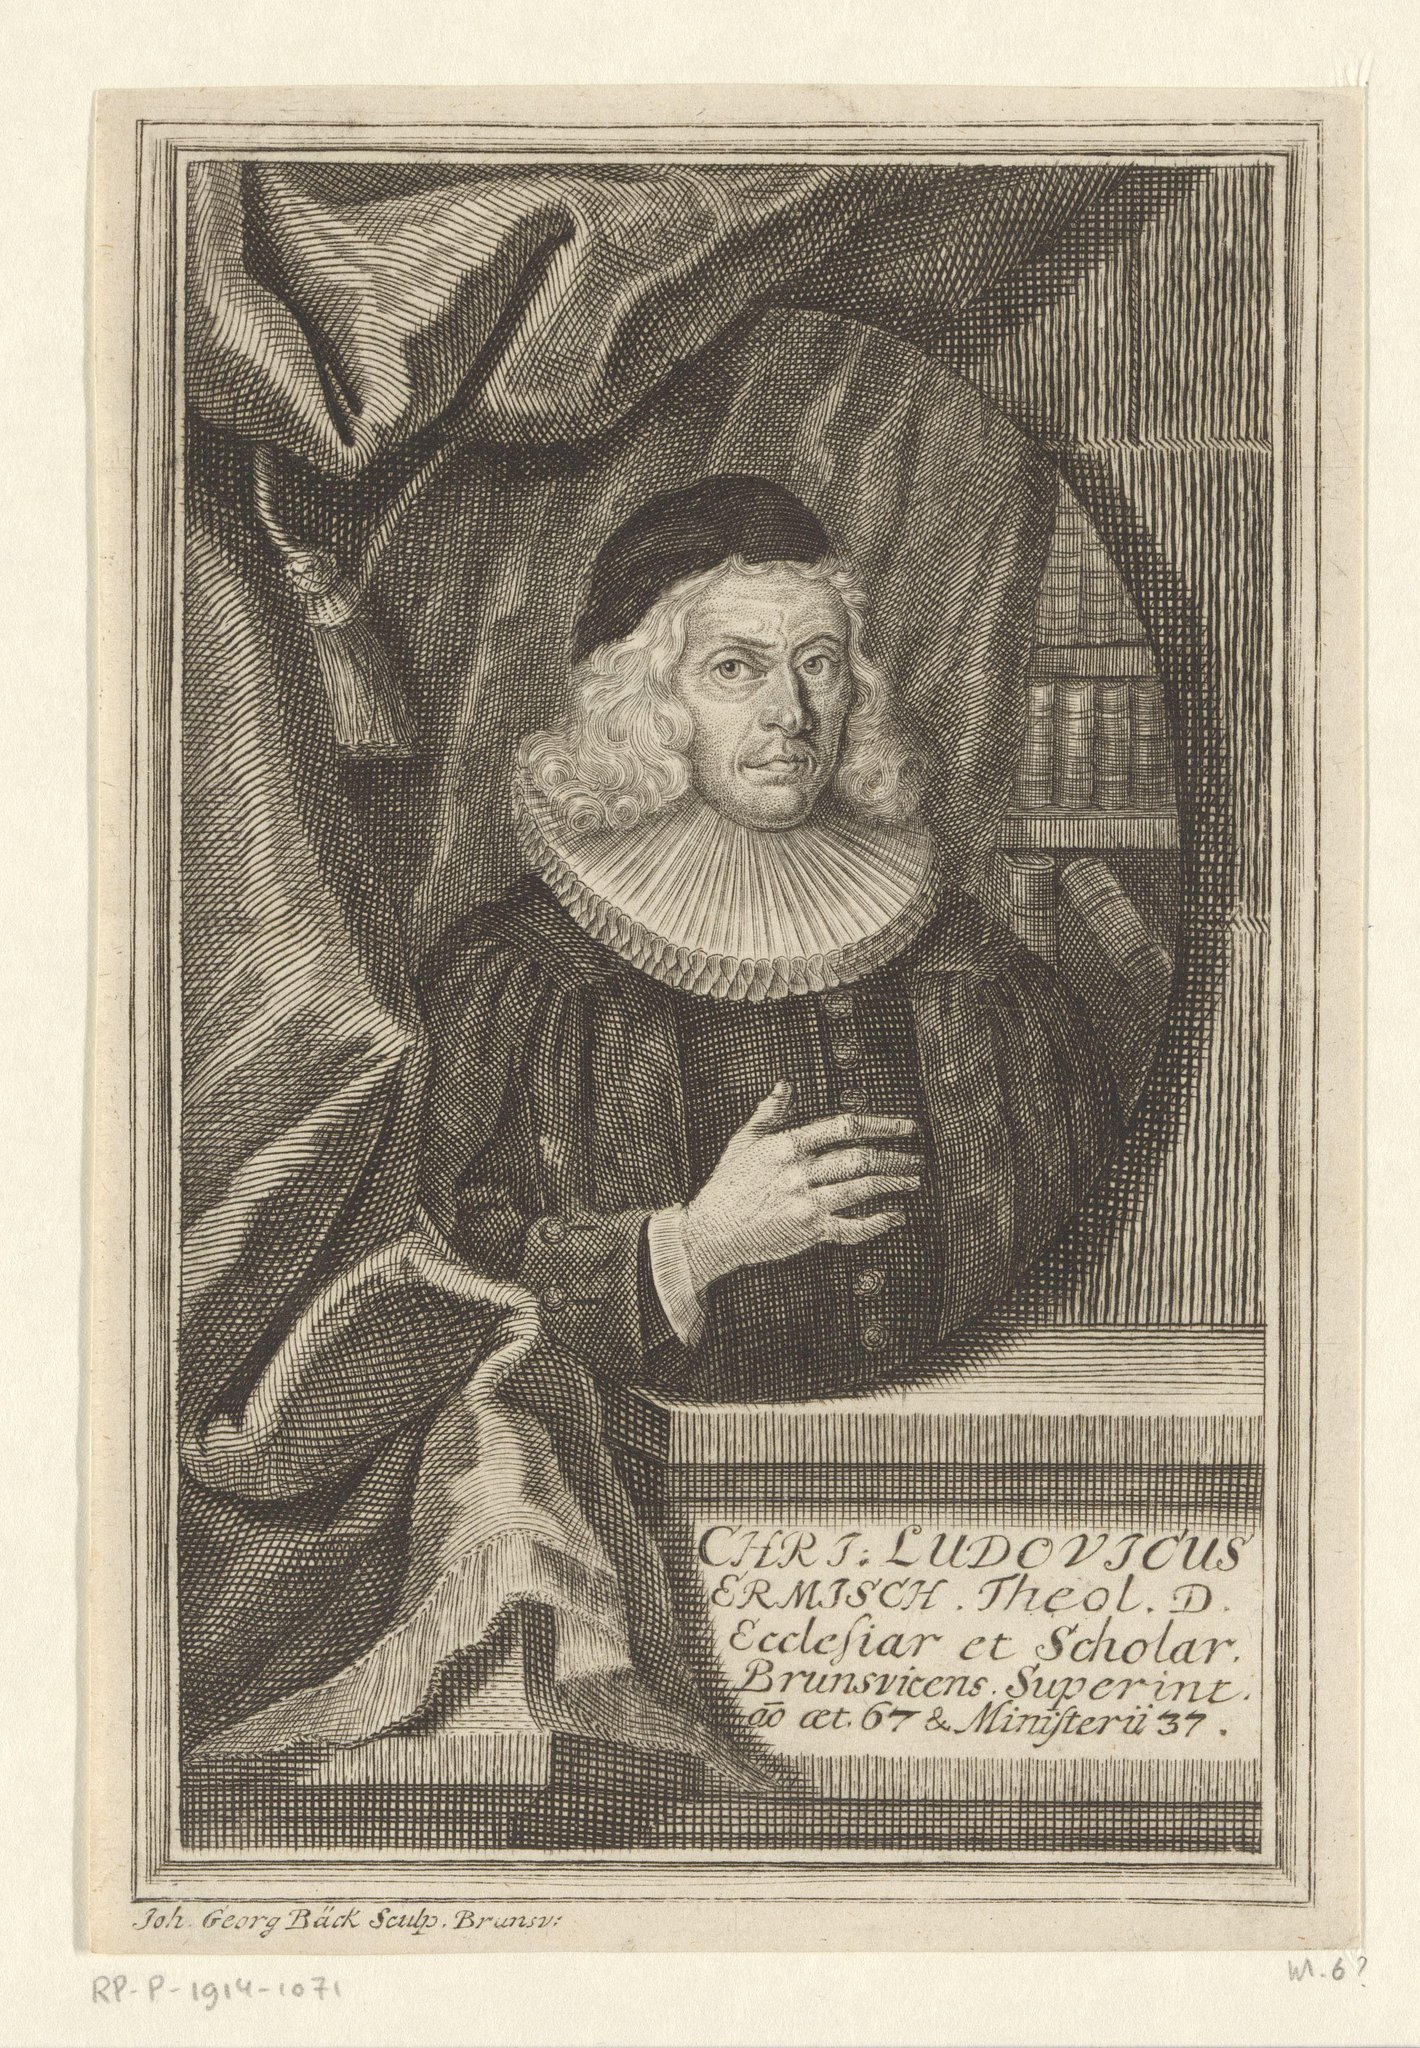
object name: print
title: Portret van Christian Ludwig Ermisch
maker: johann georg beck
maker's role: print maker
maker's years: 1676-1722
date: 1719-1732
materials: paper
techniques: engraving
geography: braunschweig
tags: bookshelves, historical persons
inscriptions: collector's mark: Lugt 2228